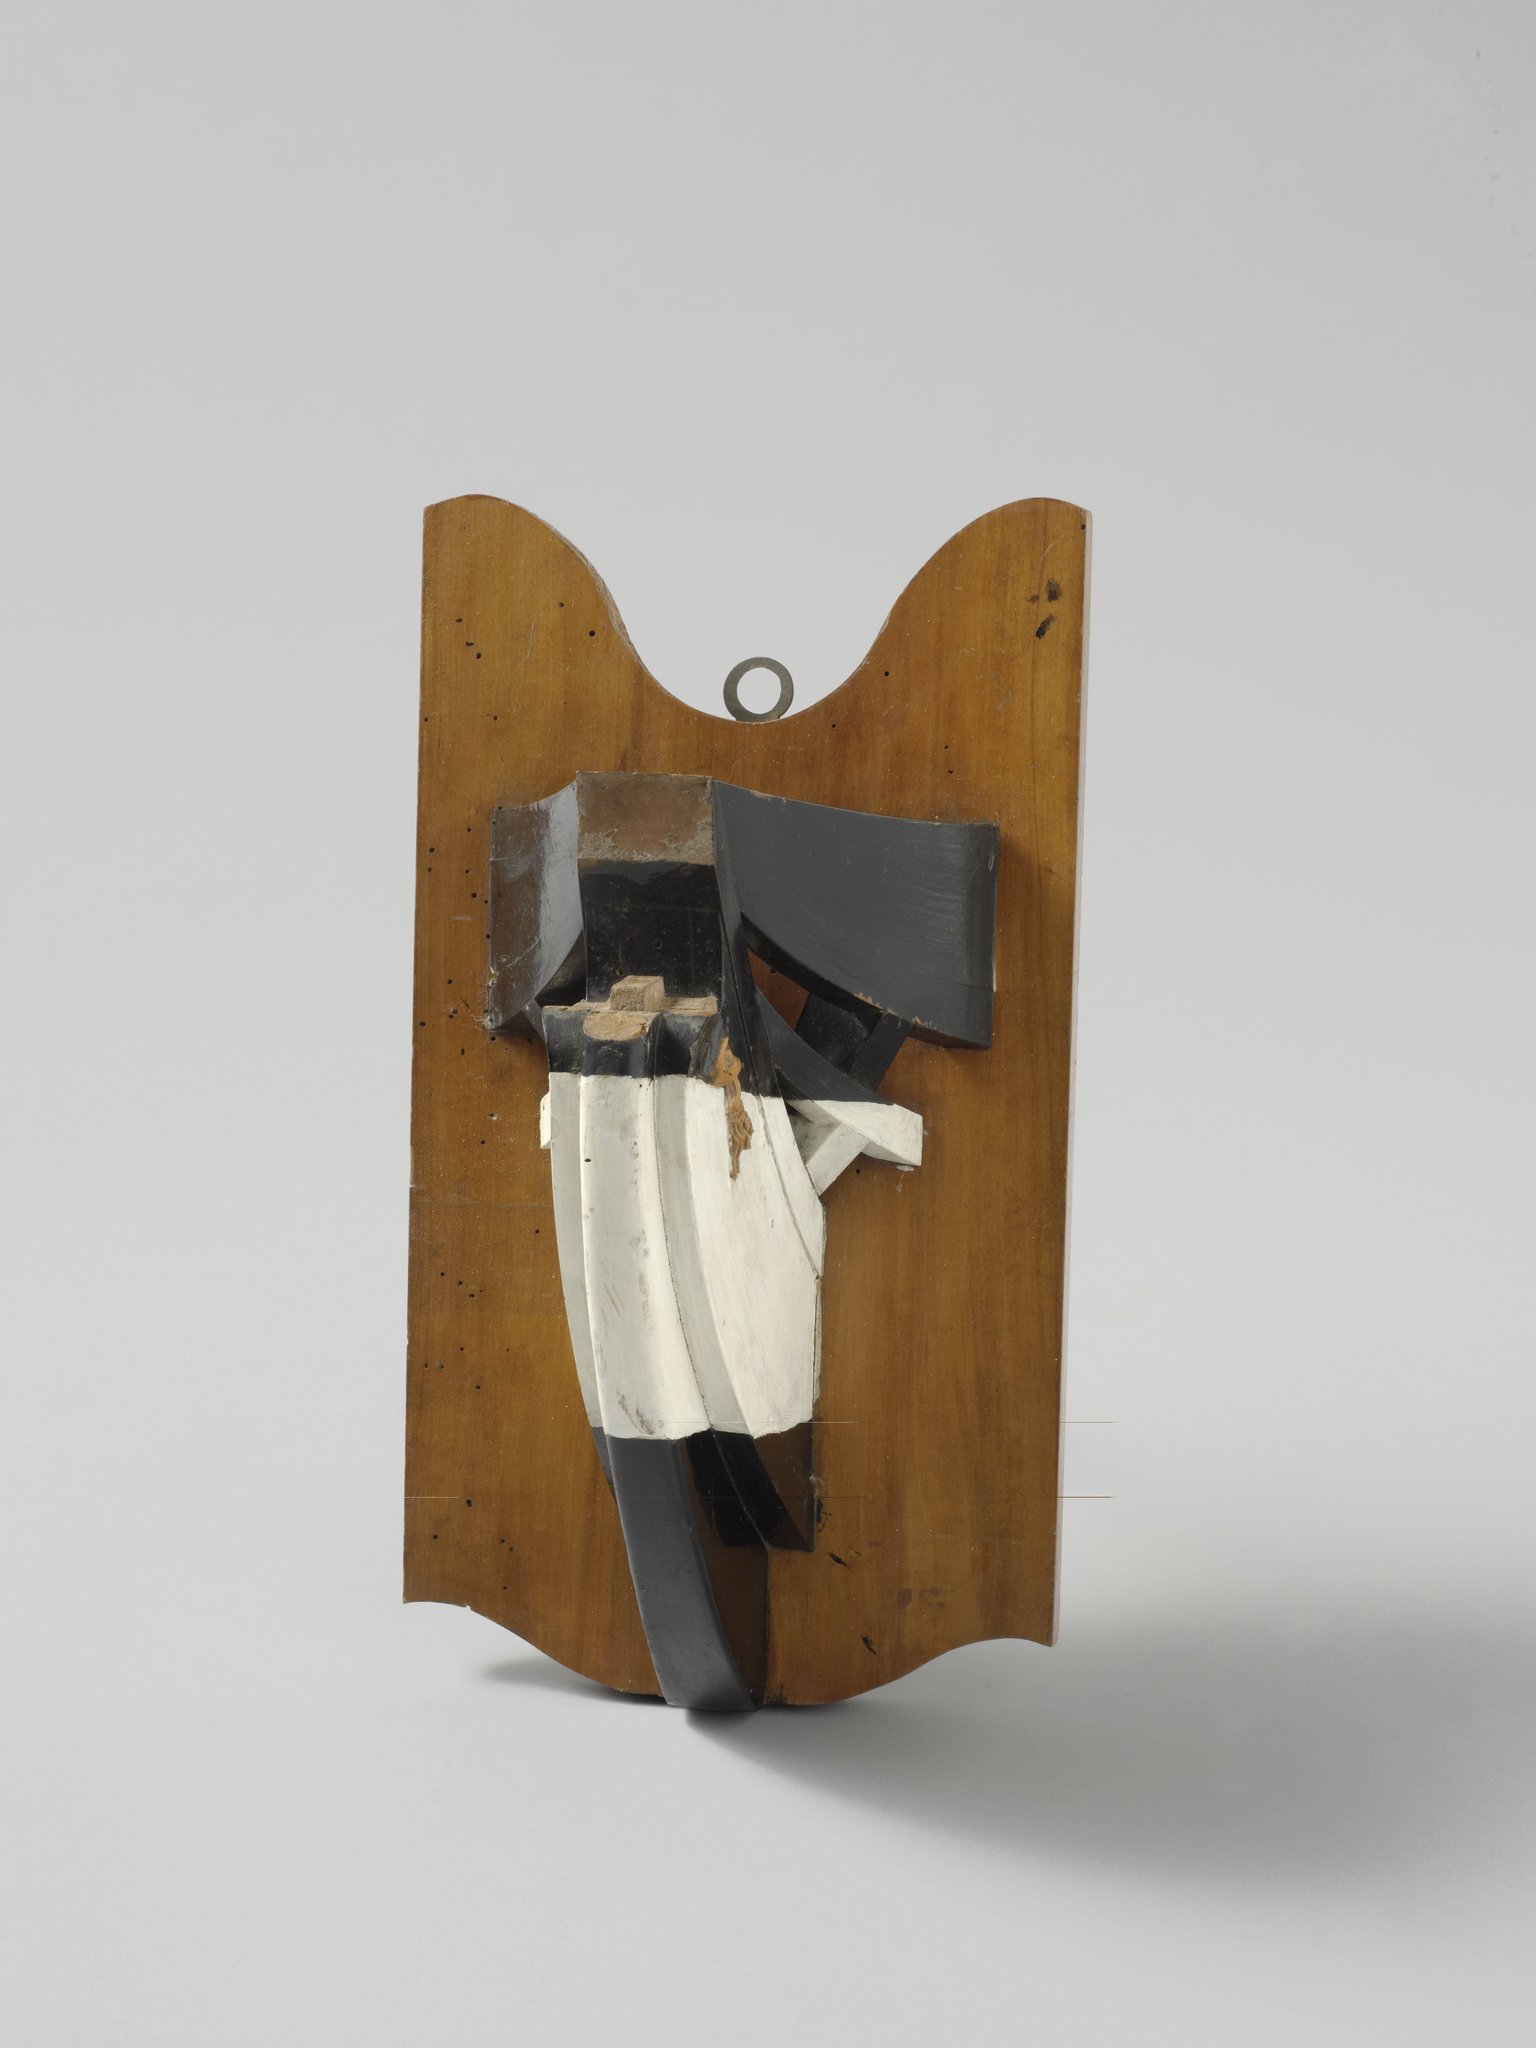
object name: scale model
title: Model of a Figurehead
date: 1847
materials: paint, wood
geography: flushing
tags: rotterdam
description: Zwart, wit en rood model van een schegbeeld op een scheg, op achterplaat: het schegbeeld zelf ontbreekt. Van oude foto's is het uiterlijk bekend: een mannelijk torso in wapenrusting met een kroon op de helm.